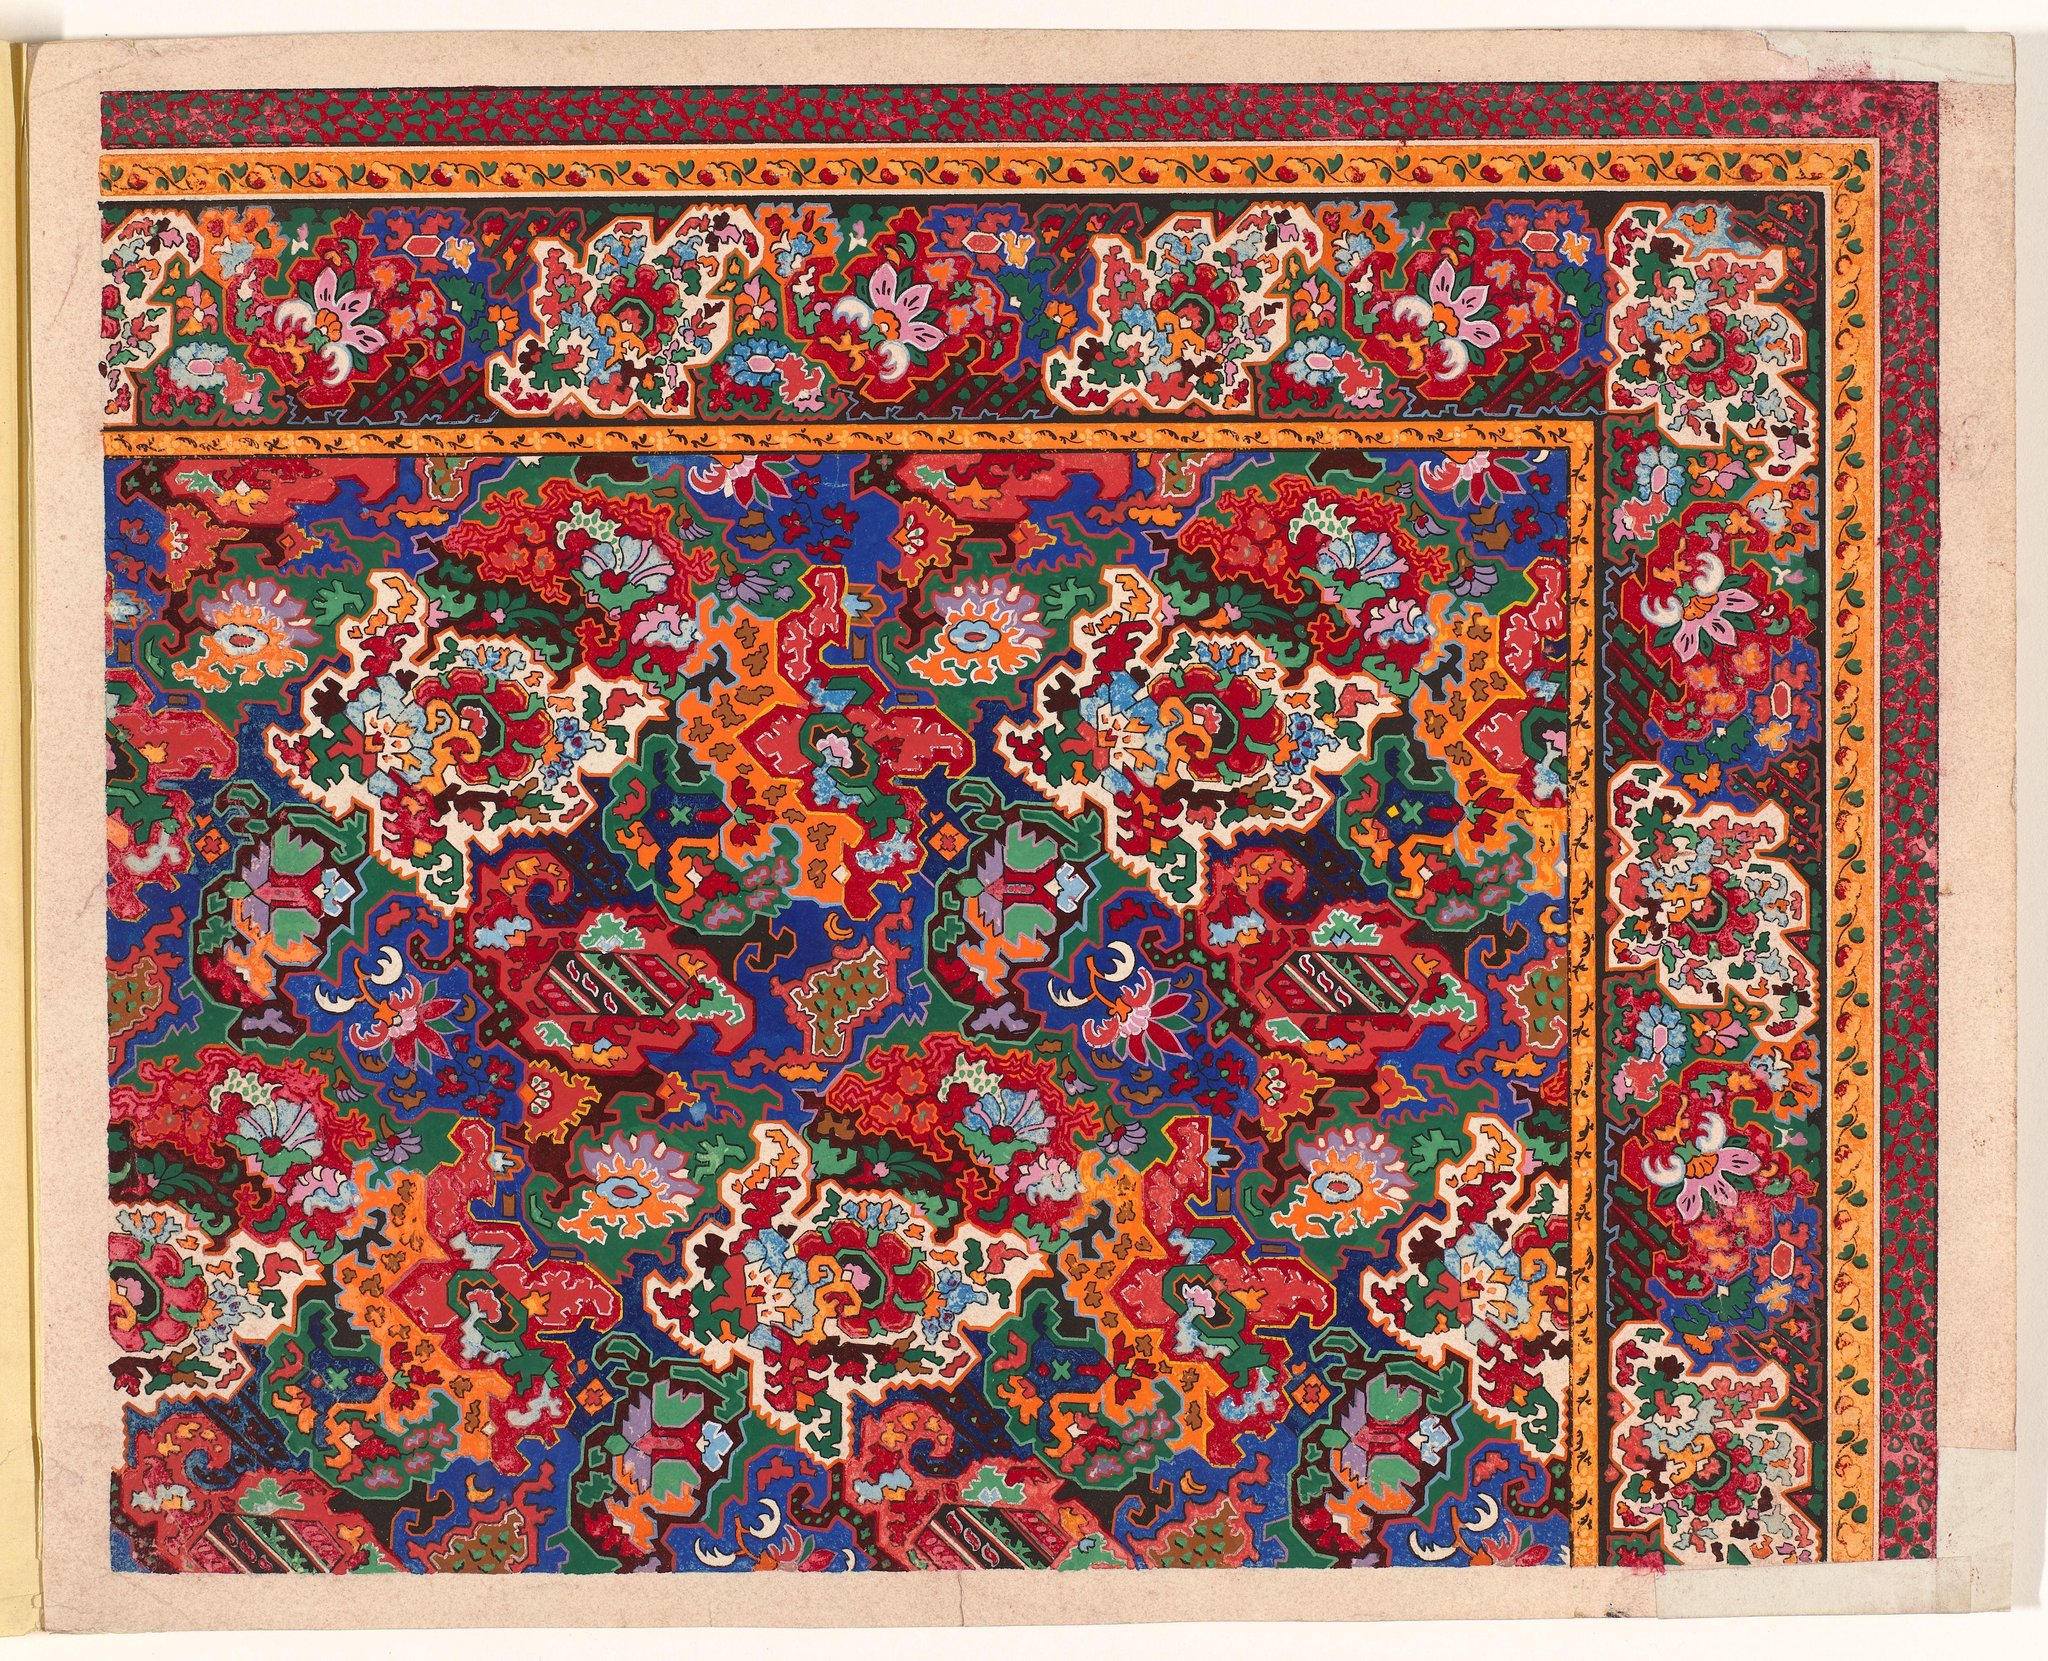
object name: drawing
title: Ontwerp voor een tapijt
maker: Anonymous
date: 1854-1864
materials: gouache, paper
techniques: brush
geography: amsterdam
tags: ornaments ~ art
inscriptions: retailer's mark: ‘JHS.’, stamp: ‘Koninklyke Tapytfabriek Firma P. van Calcar & Co’, number: ‘No 373’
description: De presentatietekeningen BK-1971-77-1 t/m 86 zijn kopieën van de originele ontwerptekeningen. Ze werden gemaakt voor vertegenwoordigers van bijvoorbeeld magazijnen, die ze aan hun klanten konden tonen. De meeste tekeningen tonen een kwart van het dessin inclusief rand, middenpartij (de zogenaamde grond of fond) en centraal medaillon. Door het gebruik van spiegels kan de illusie van het gehele tapijt worden opgeroepen. Een deel van de tekeningen heeft een alfabetische opeenvolgende letter als kenmerk, de andere groep een cijfer.Waarschijnlijk is de reeks dessins met een letter eerder samengesteld dan de genummerde tekeningen.